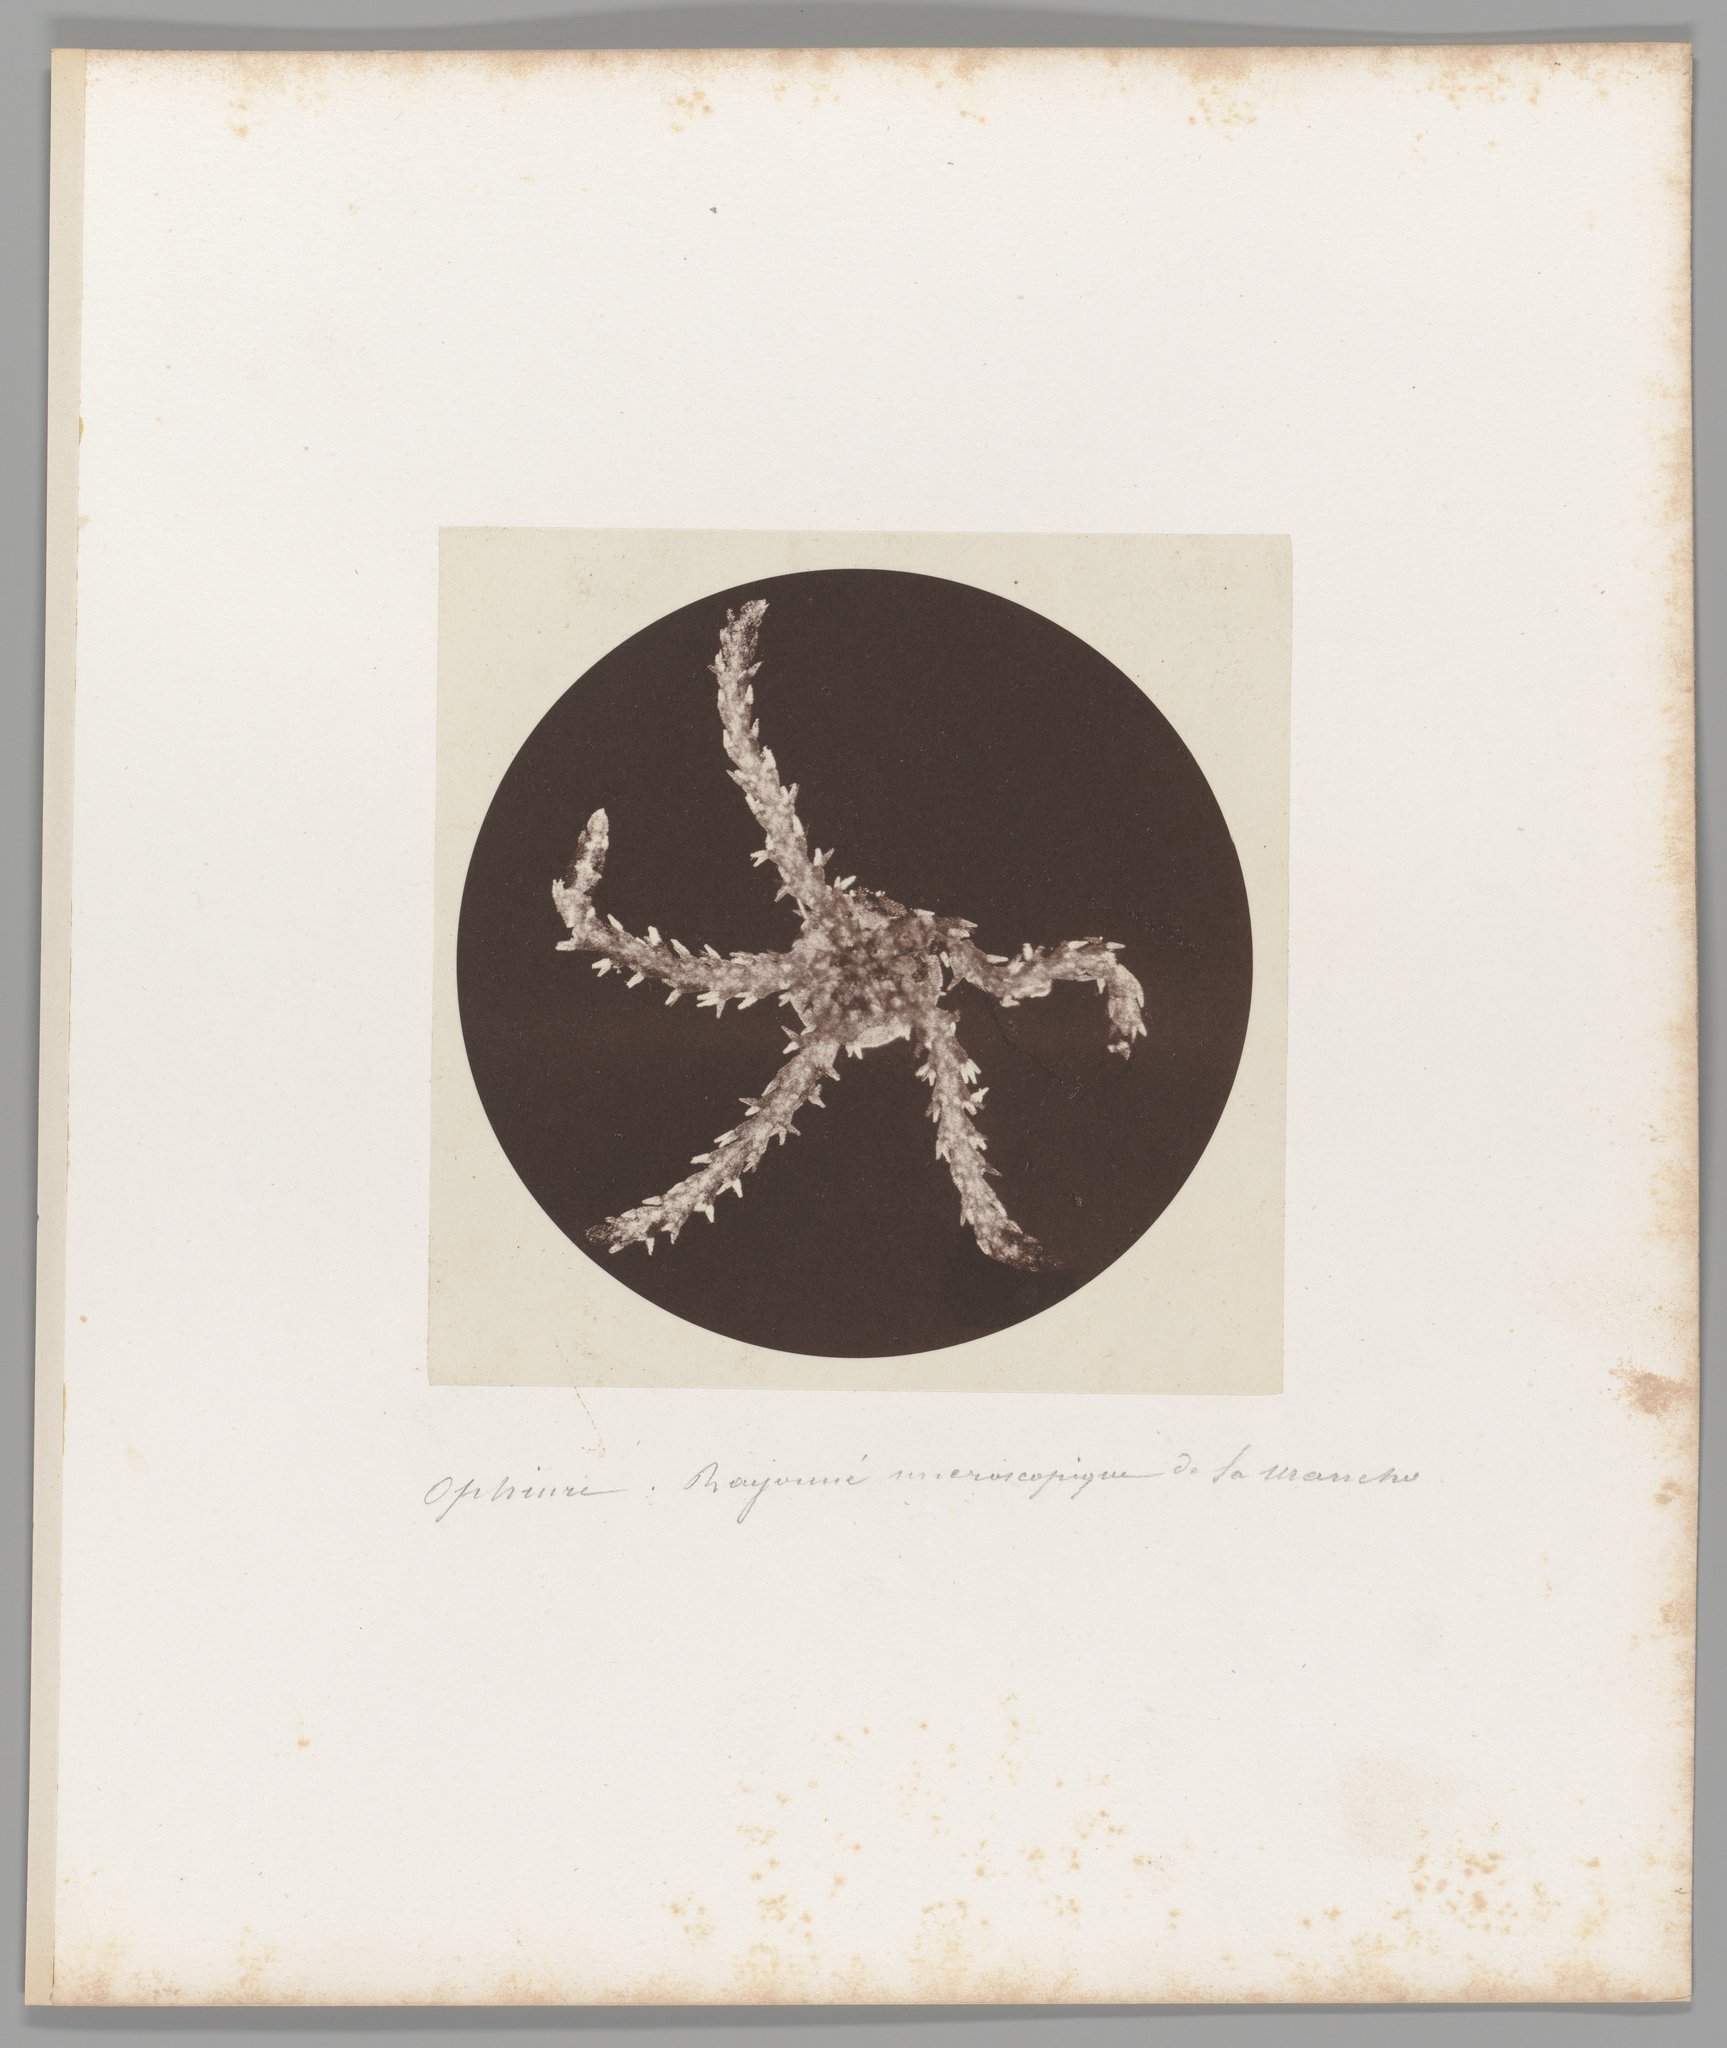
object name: photograph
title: [Untitled]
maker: auguste-adolphe bertsch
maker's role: artist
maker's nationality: french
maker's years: 1813-1871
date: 1853-1857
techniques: salted paper print